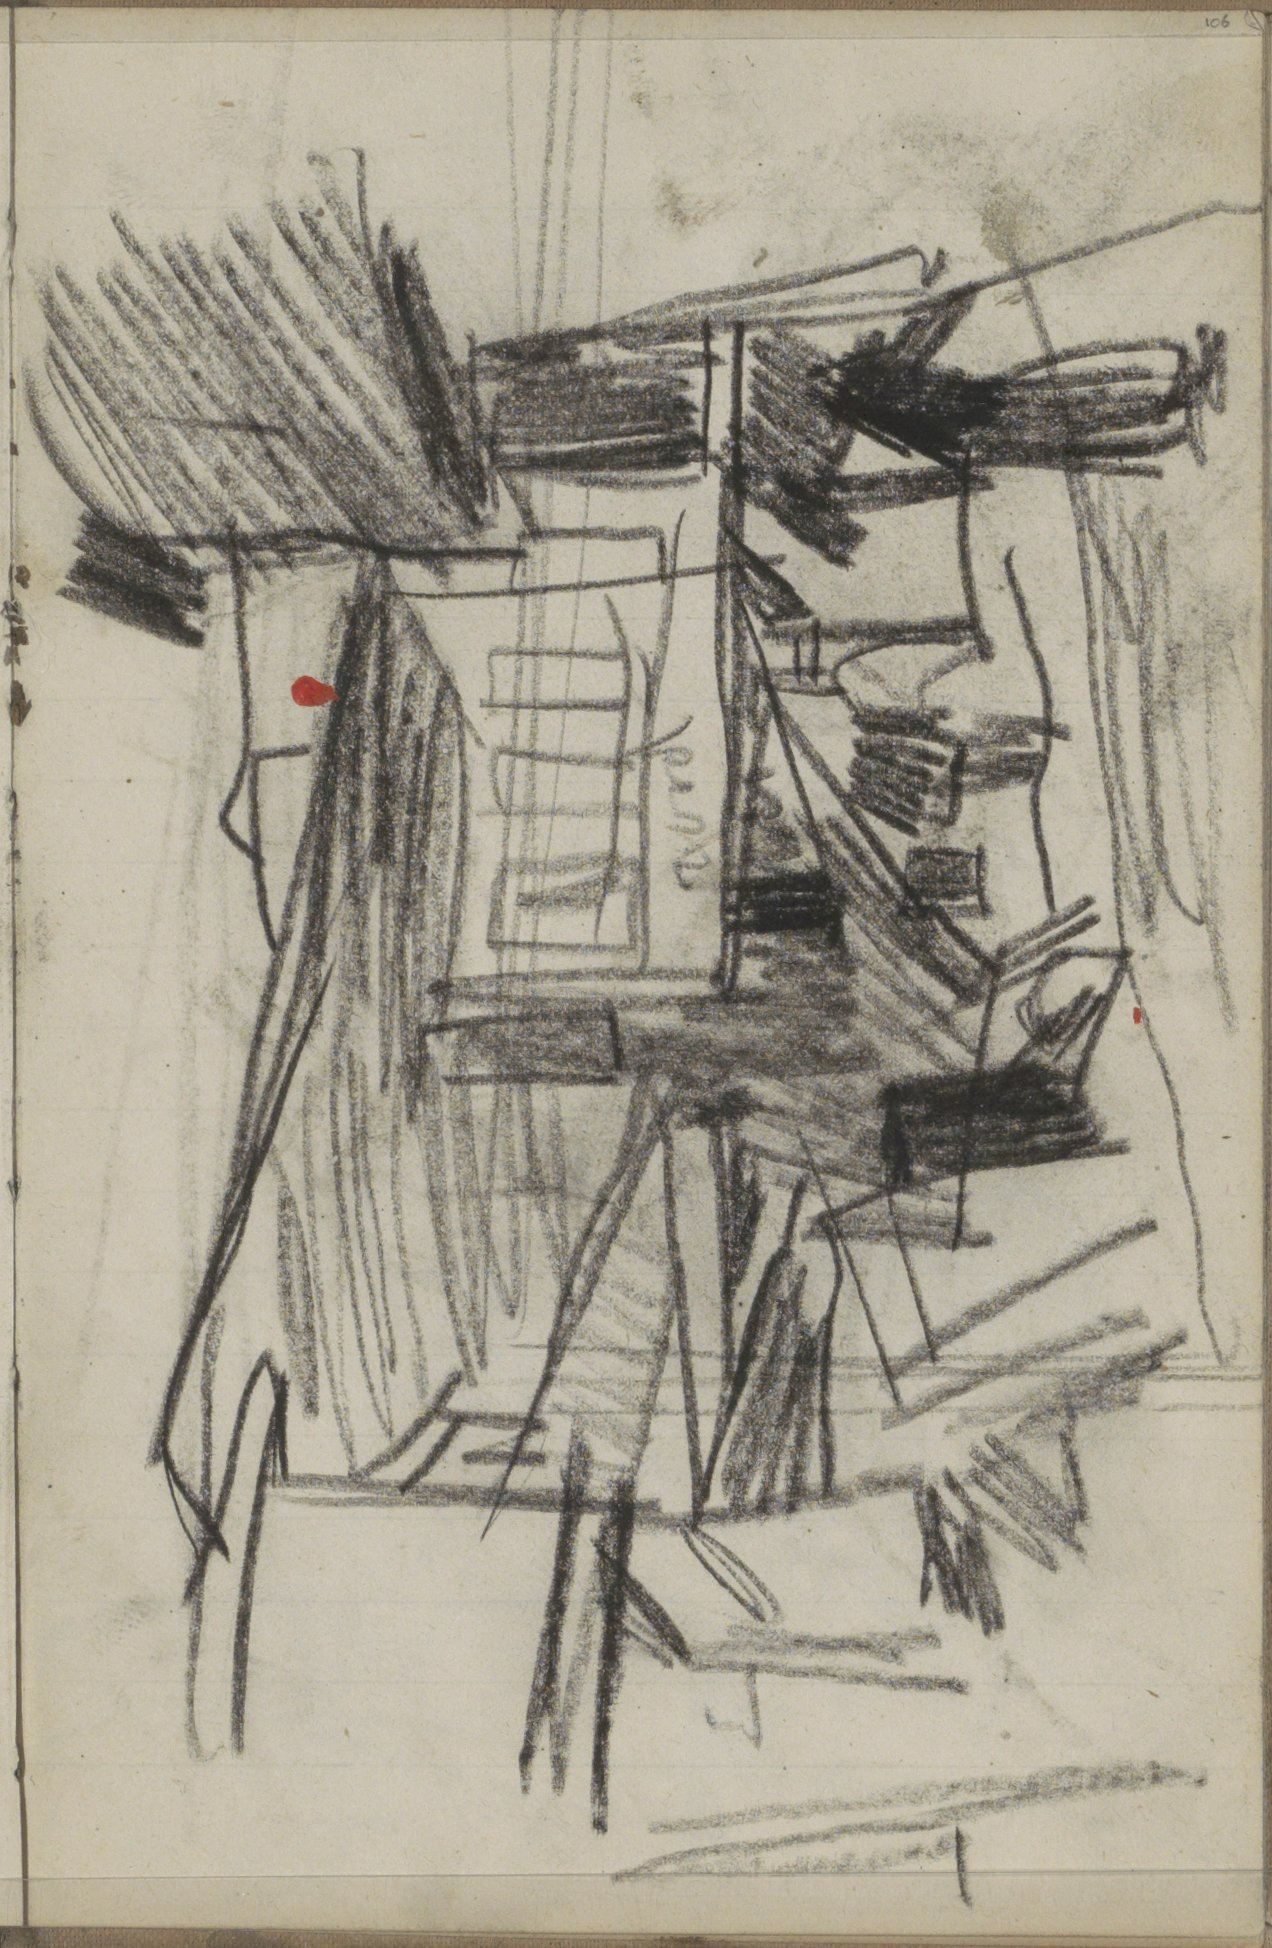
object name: sketchbook leaf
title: Huizen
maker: marius bauer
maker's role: draughtsman, print maker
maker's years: 1867-1932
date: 1888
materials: chalk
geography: istanbul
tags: housing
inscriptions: kleurnotitie, handgeschreven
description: Met op de voorgrond mogelijk een figuur. Pagina 106 uit een schetsboek met 56 bladen.